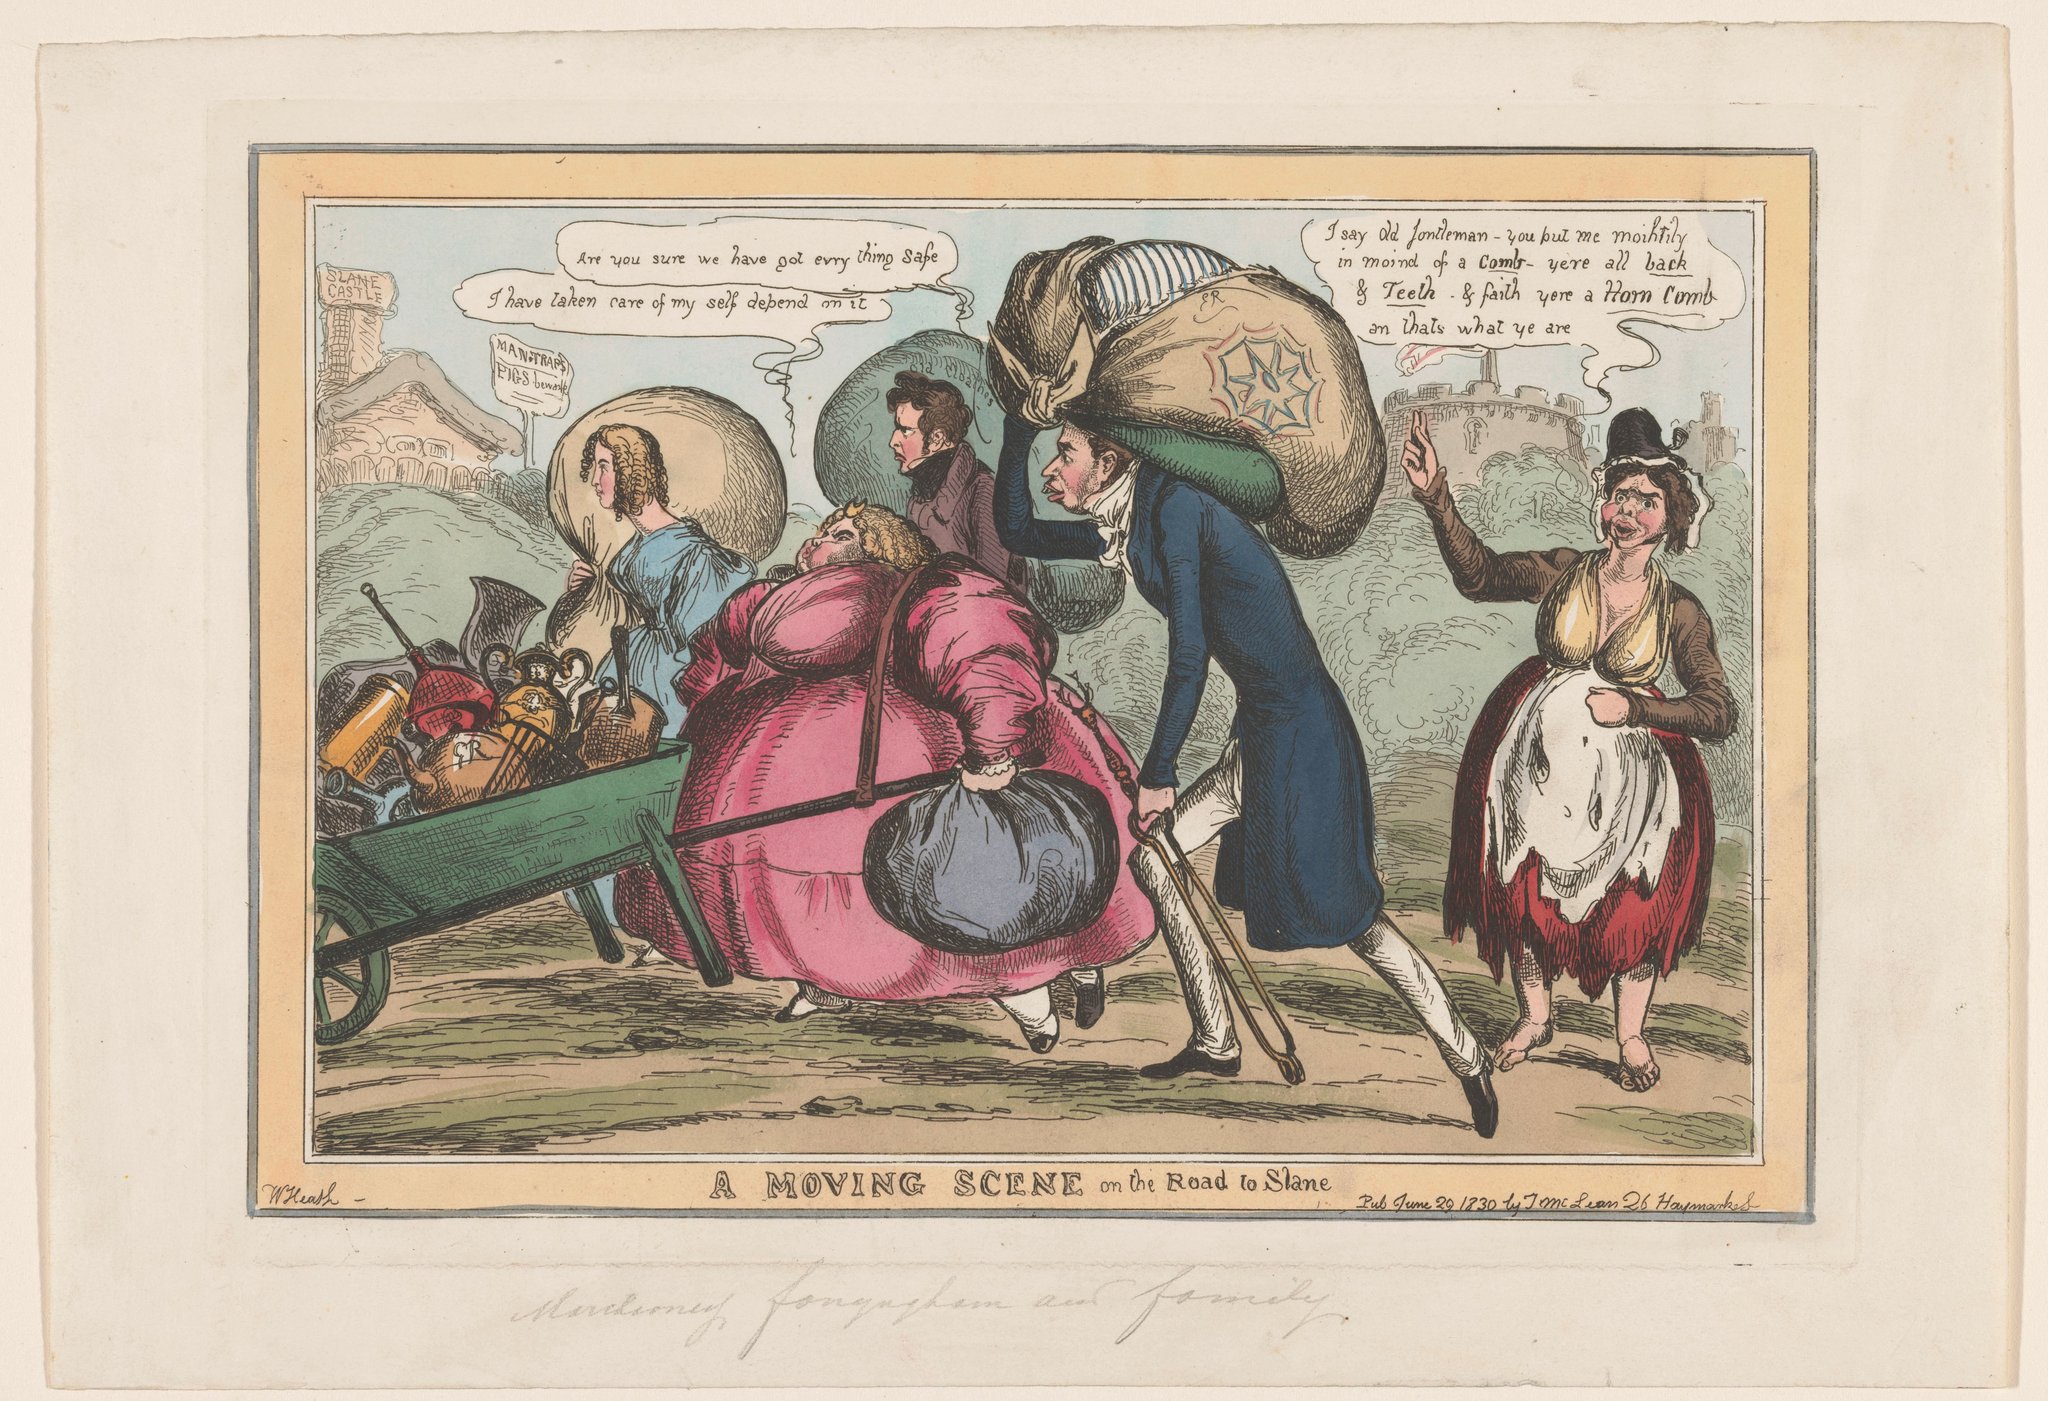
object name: cartoon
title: A moving scene on the road to Slane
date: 1830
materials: paper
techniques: etching, hand coloring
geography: england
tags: george iv (koning van het verenigd koninkrijk), moving (house), wheelbarrow, political caricatures and satires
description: De Conyngham familie verhuist van Windsor Castle naar Slane Castle, 1830. De ronde Lady Conyngham, maîtresse van koning George IV, duwt een kruiwagen beladen met spullen, Lord Conyngham loopt achter haar met een grote zak op zijn hoofd. Ze worden door een vrouw en vodden nageroepen.